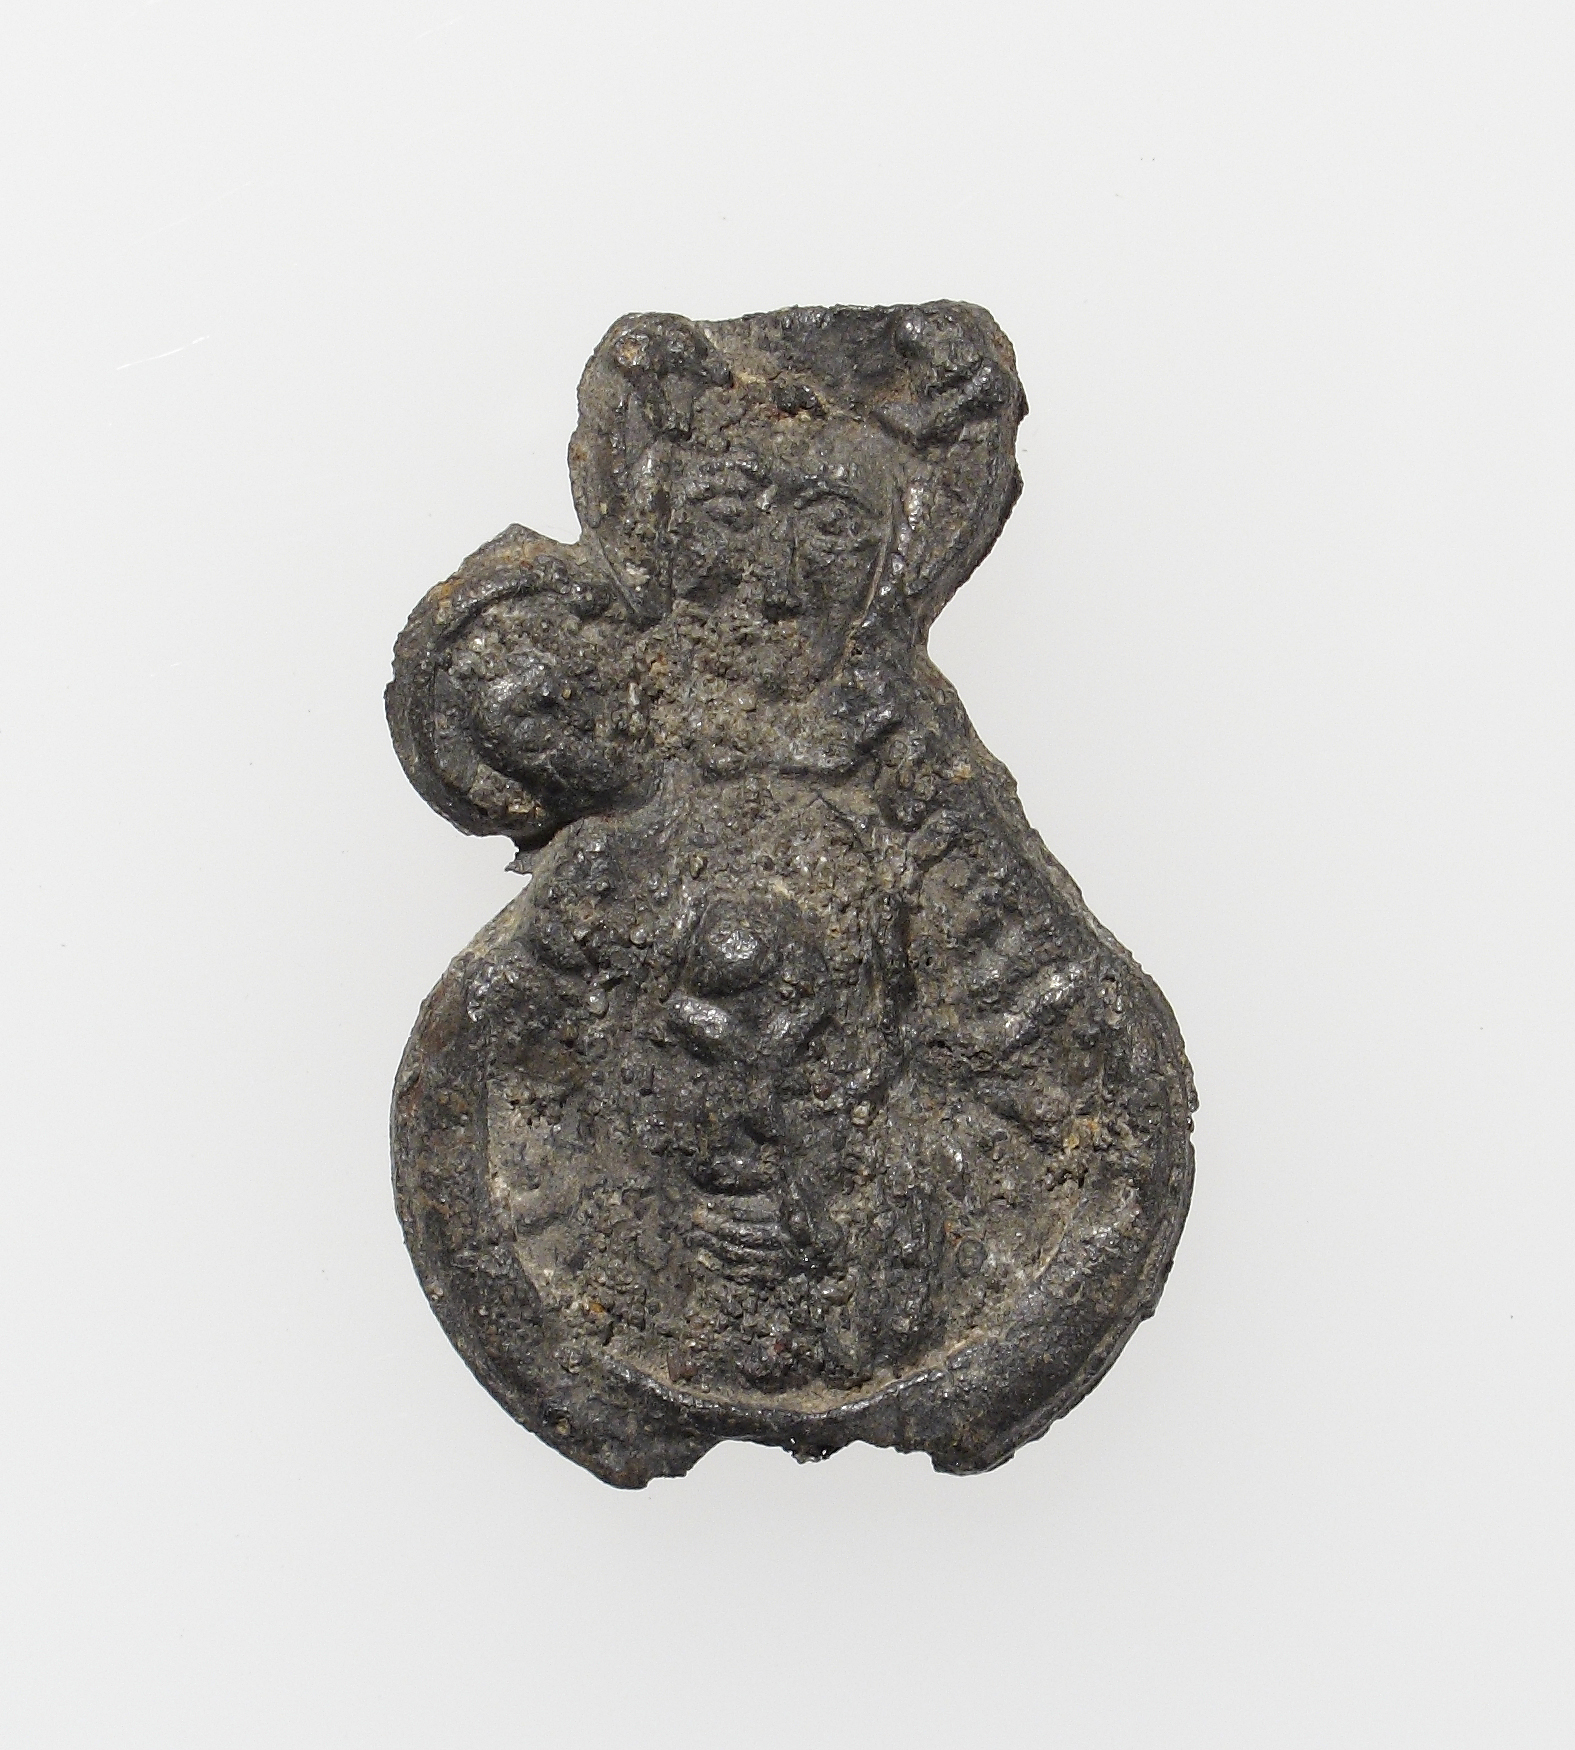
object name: pilgrim's badge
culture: french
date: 1301-1600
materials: lead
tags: madonna and child